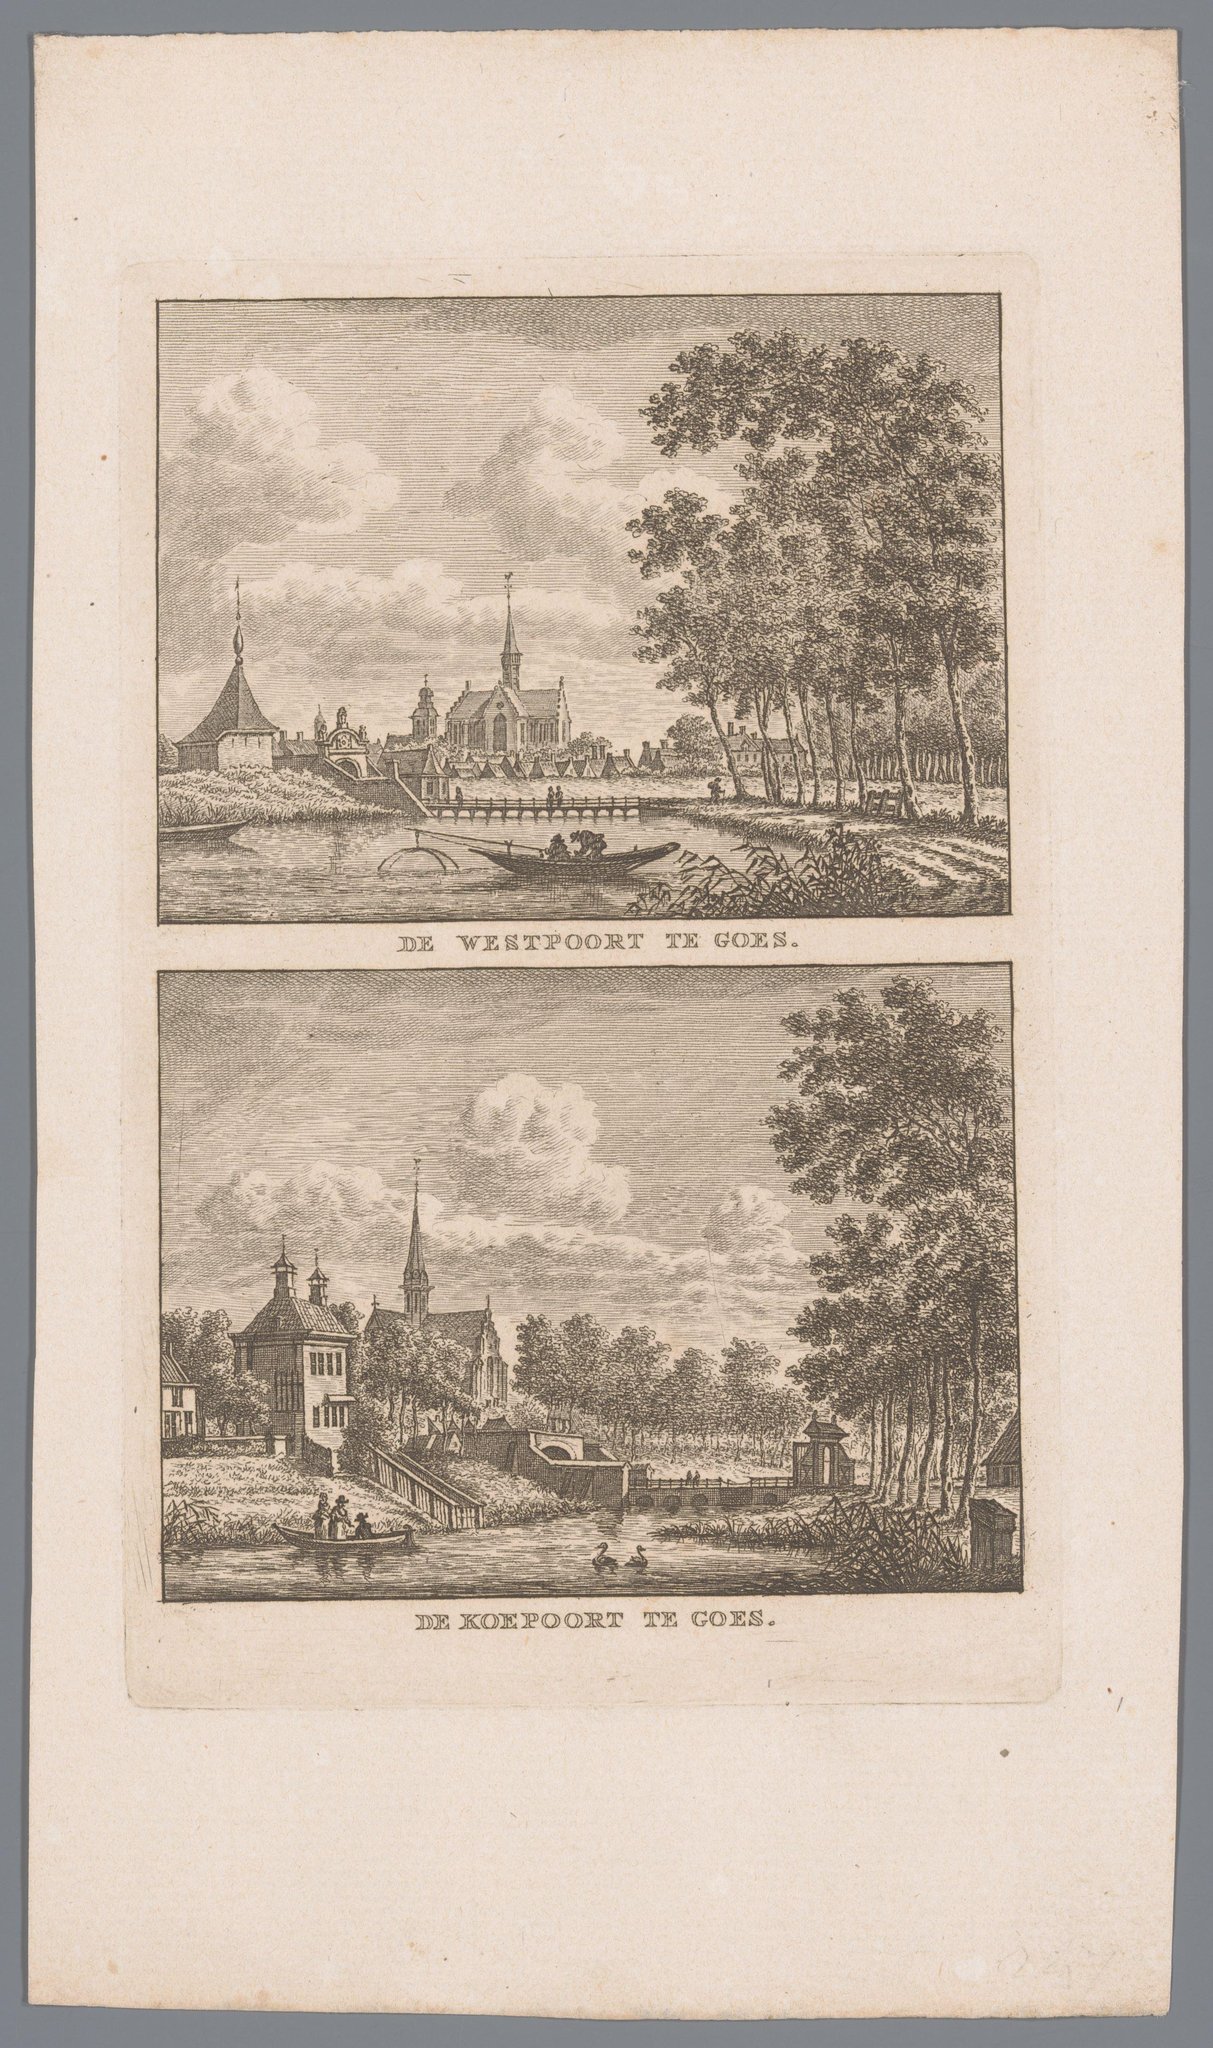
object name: print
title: Twee stadgezichten te Goes met de Westpoort en de Koepoort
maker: carel frederik bendorp (i)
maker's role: print maker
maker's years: 1736-1814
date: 1786-1792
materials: paper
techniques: etching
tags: city-gate, middelburg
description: Prent uit: Vaderlandsche gezichten, of afbeeldingen van den tegenwoordigen staat der Vereenigde Nederlanden (…). Amsterdam: Hendrik Gartman, Willem Vermandel en Jan Willem Smit, 1786-1792. Uitgegeven in afleveringen met ieder een eigen bifolium en inhoudsopgave. Alle prenten in deze publicatie zijn gegraveerd door Carel Frederik Bendorp (I) en, in de meeste gevallen, gebaseerd op tekeningen van Jan Bulthuis.